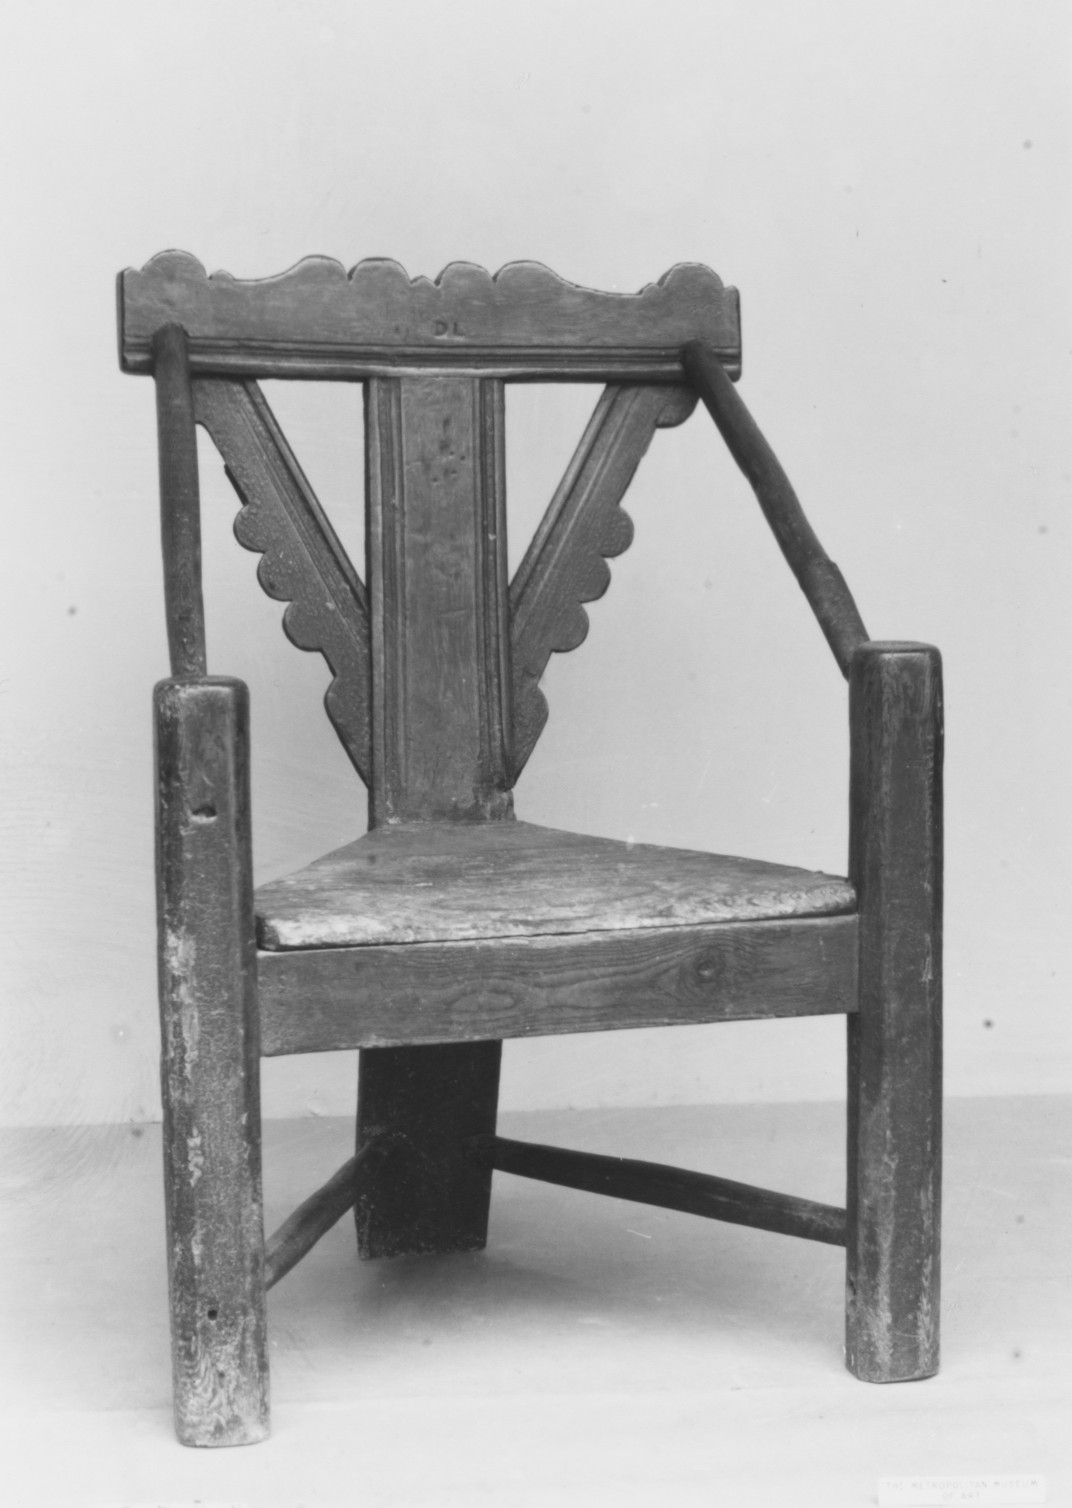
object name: armchair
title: Three-legged Armchair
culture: british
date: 1650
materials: wood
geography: england